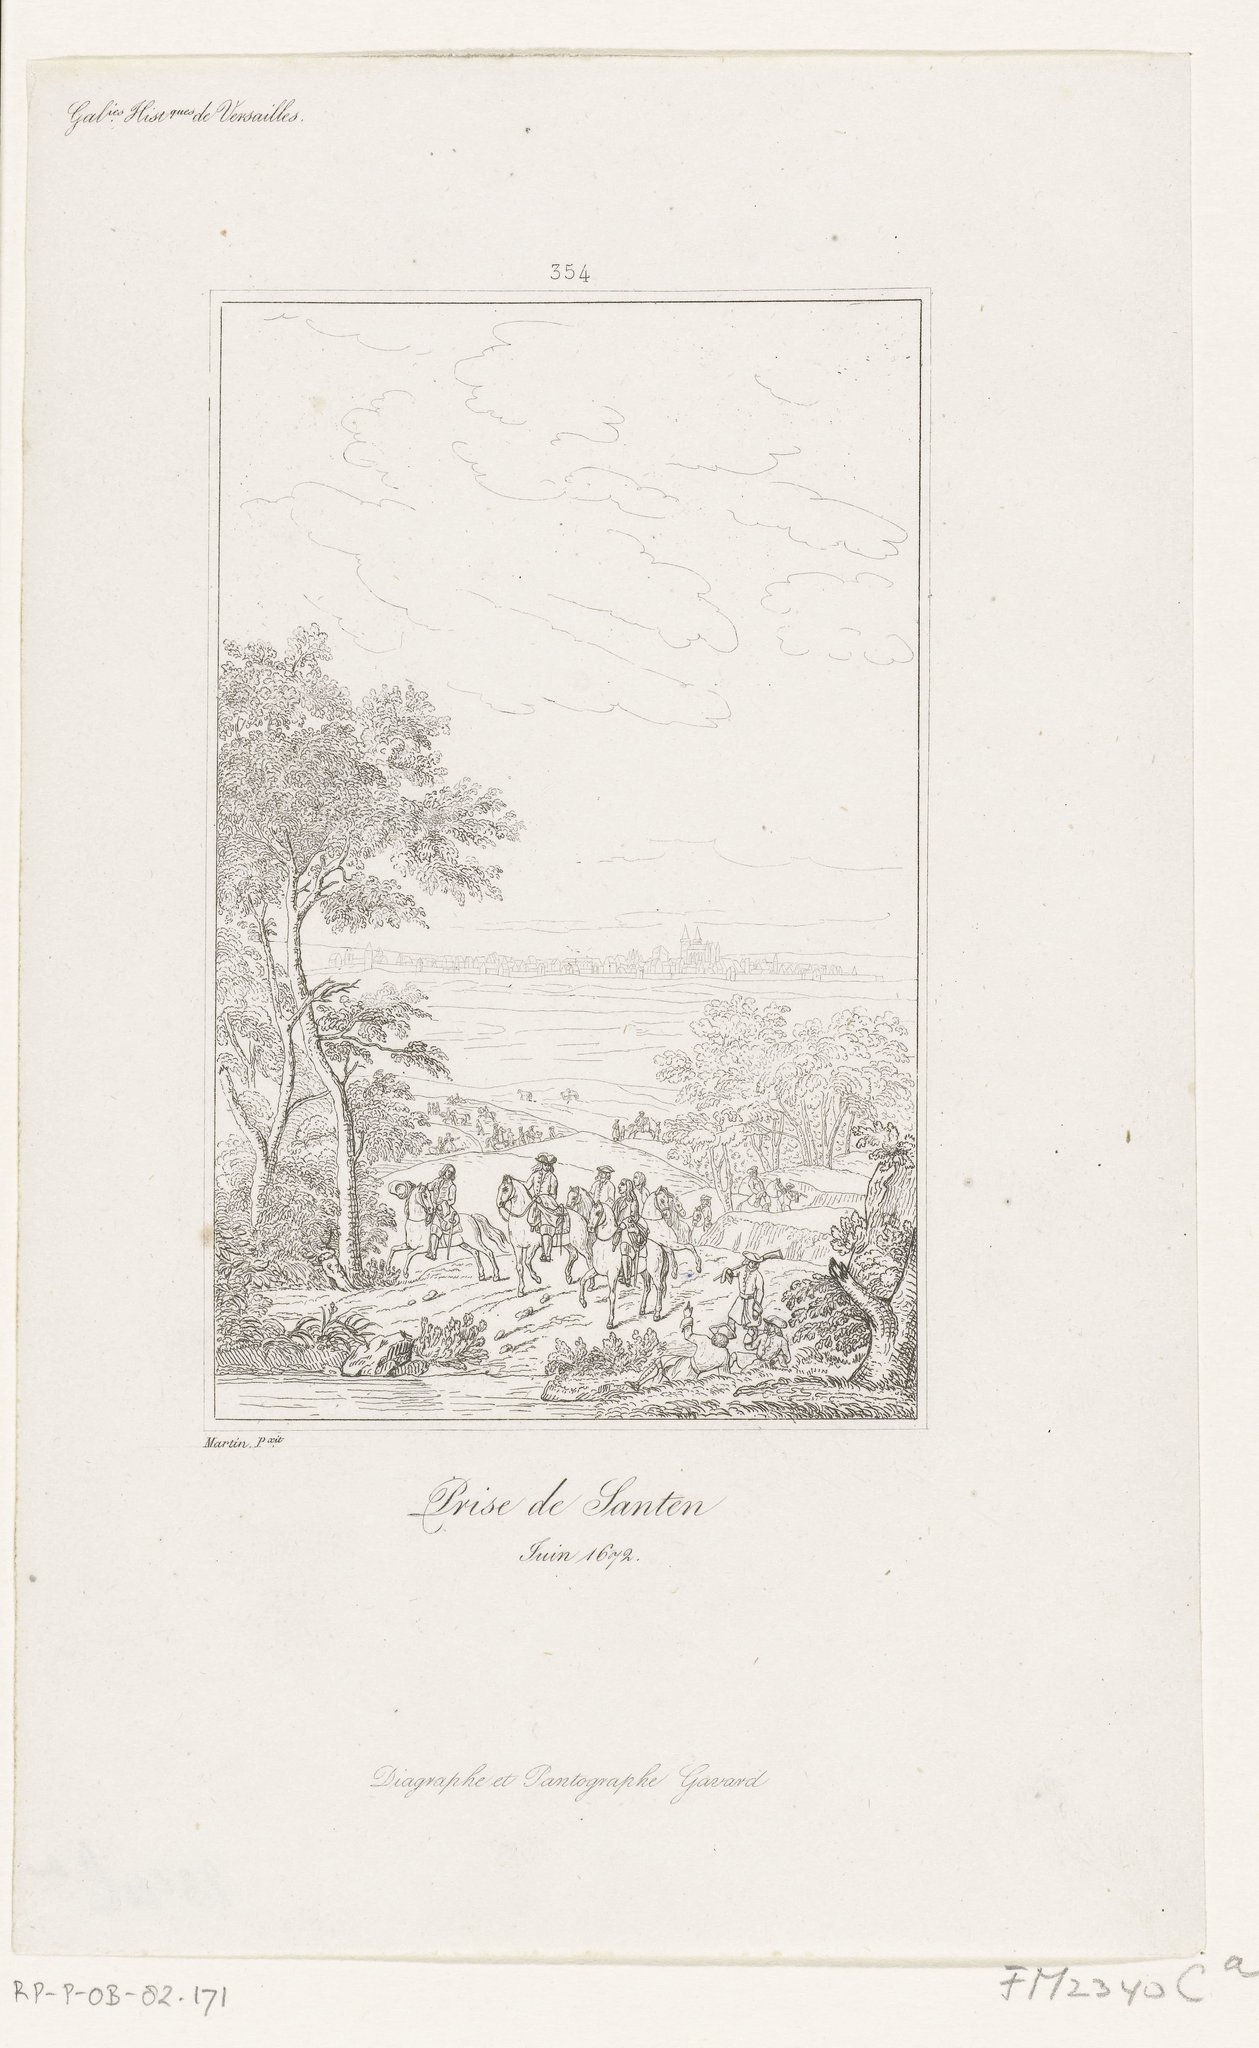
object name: print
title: Prise de Santen, Juin 1672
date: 1835-1840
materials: paper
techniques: etching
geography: france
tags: lodewijk xiv (koning van frankrijk), capture of city (after the siege), rampjaar (disaster year)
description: Gebruikt als illustratie in: C. Gavard, Galeries historiques de Versailles, collection de gravures réduites d'après les dessins originaux du grand ouvrage, Parijs 1840, nr. 354. Niet in Frederik Muller; door het RPK toegevoegd nummer. Op de prent vermeld: Diagraphe et Pantographe Gavard.